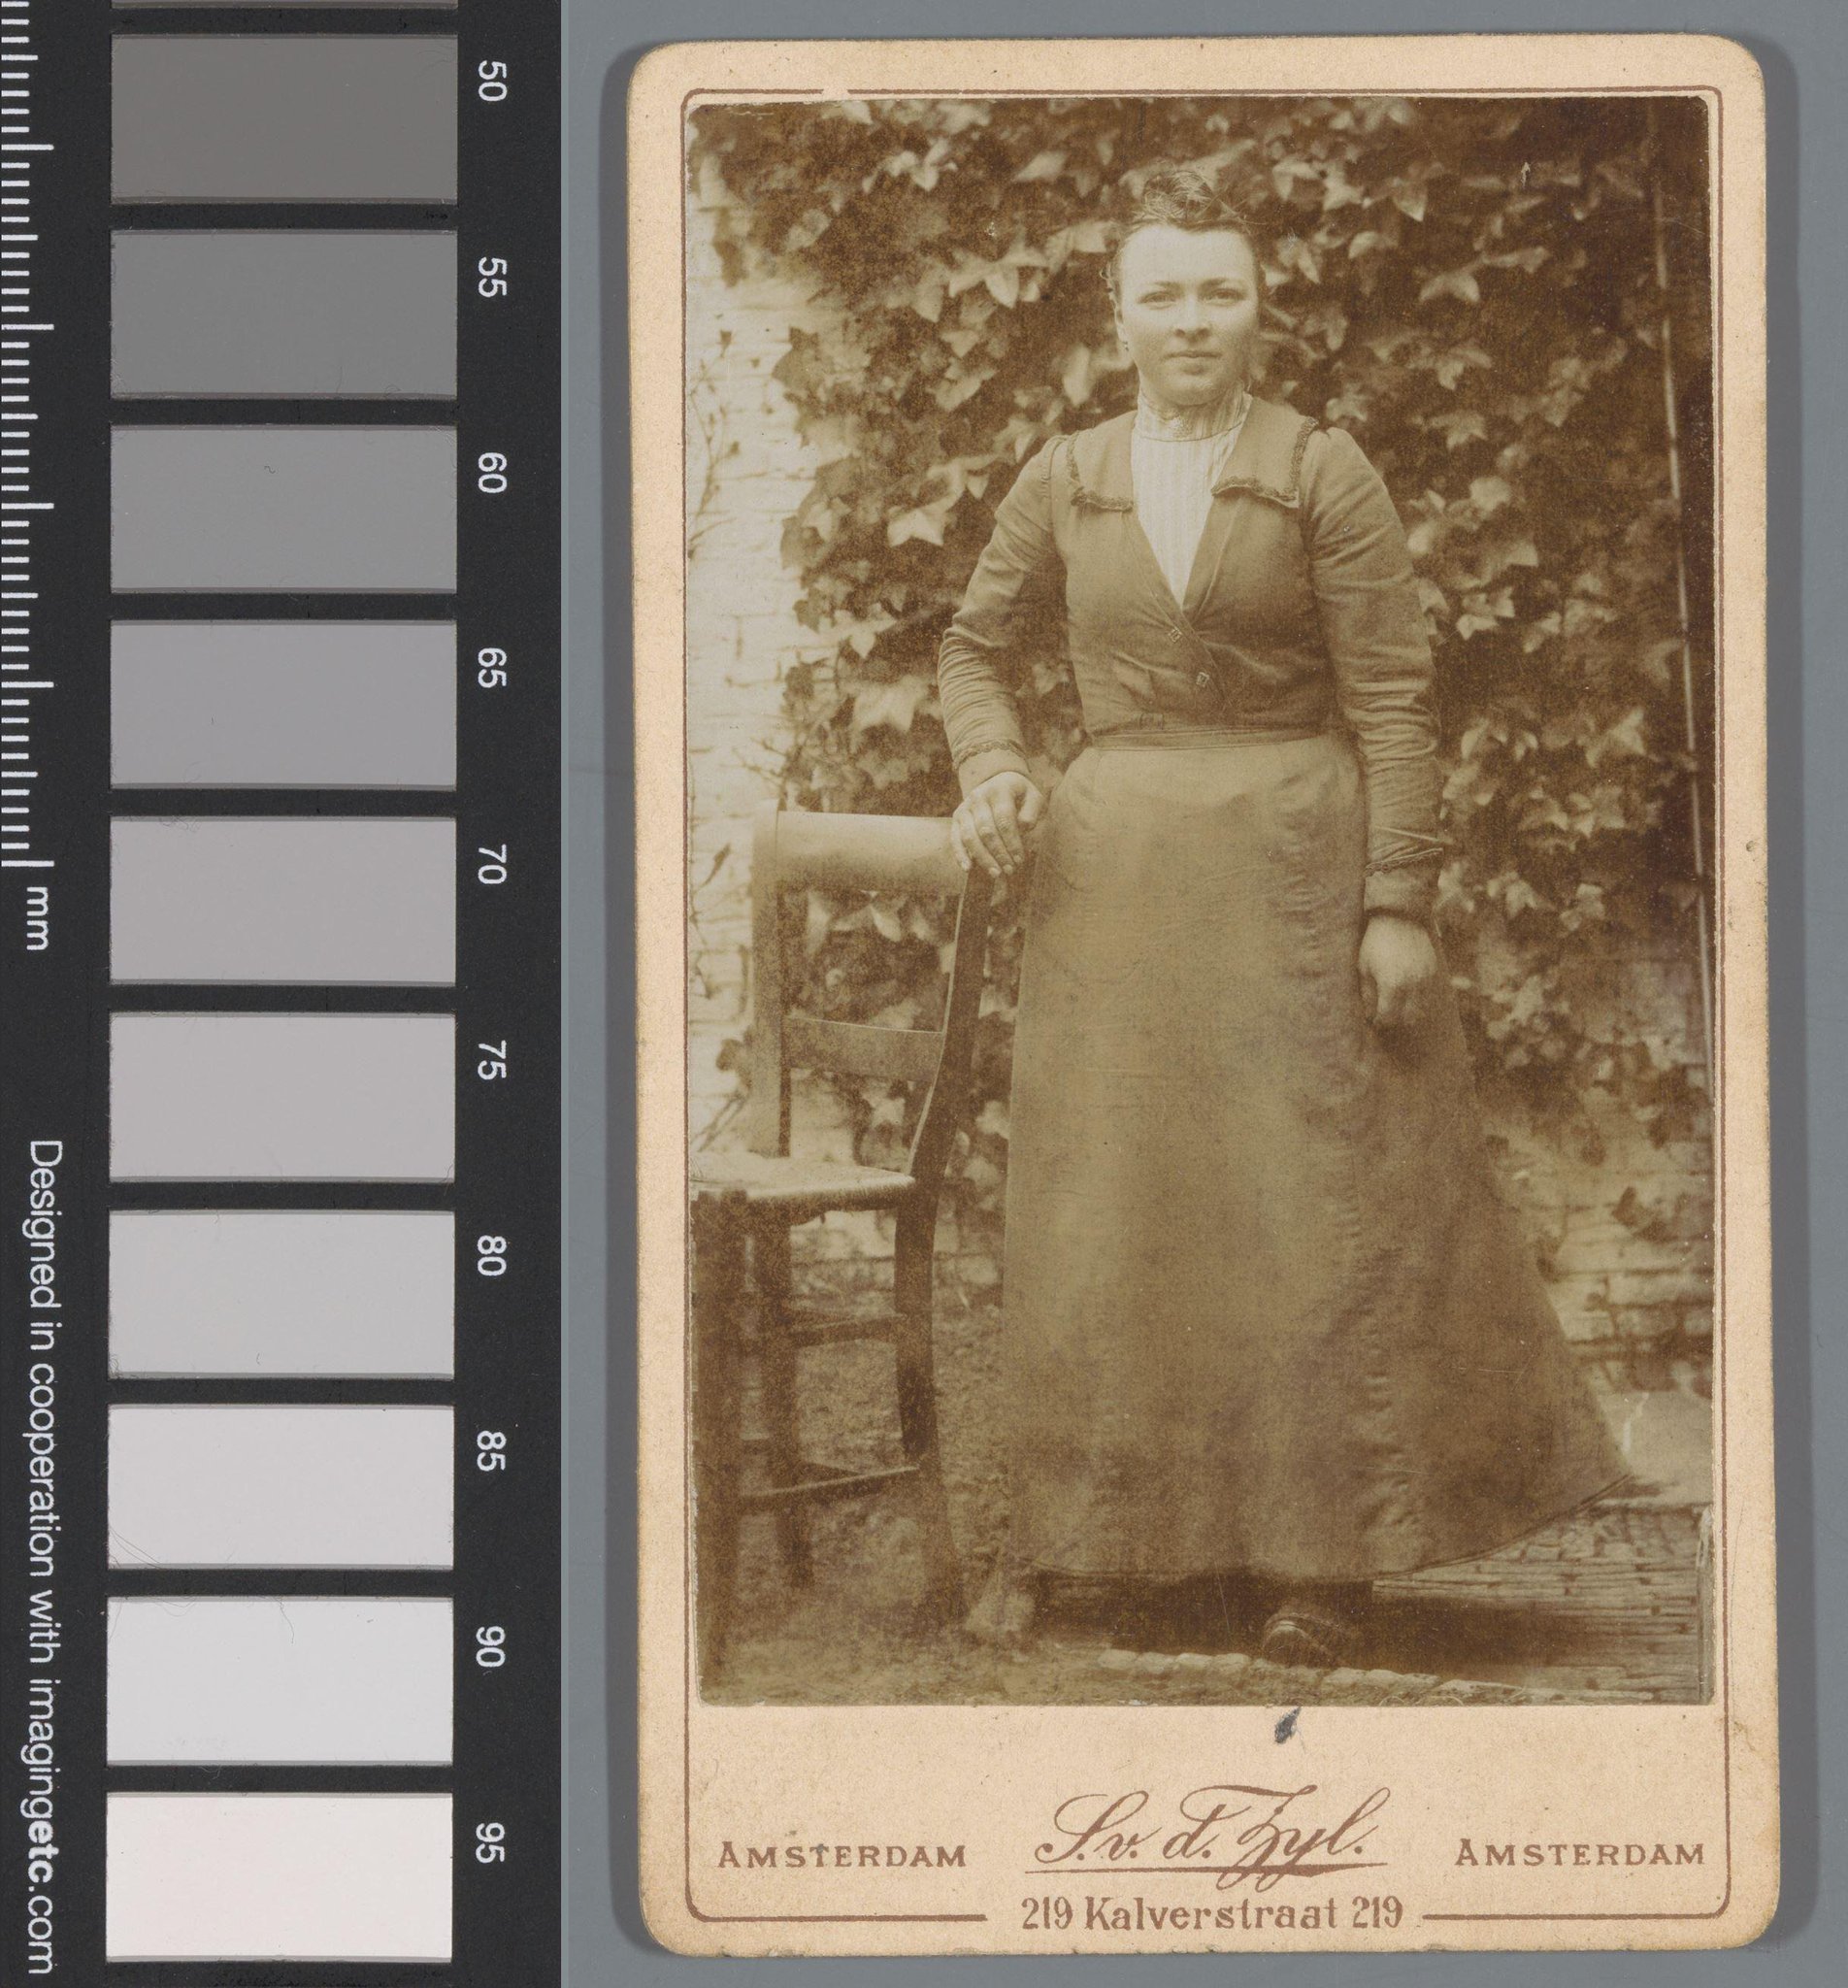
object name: carte de visite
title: Portret van een onbekende vrouw buiten bij een muur met klimop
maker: sander van der zijl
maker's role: fotograaf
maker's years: 1852-1935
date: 1901-1907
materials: paper, cardboard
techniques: gelatin silver print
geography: amsterdam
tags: adult woman, anonymous historical person portrayed, amsterdam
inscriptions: inscription: ‘Amsterdam/ S.v.d.Zijl./ Amsterdam/ 219 Kalverstraat 219.’, inscription: ‘Photographisch Atelier/ van/ Sander van der Zijl/ Amsterdam/ 219 Kalverstraat 219 b/d. Munt./ Voorheen gevestigd Nieuwendijk b/d. Dam./ Specialiteit in Kinderopnamen./ Vergrootingen van deze en andere Portretten/ tot levensgroote./ N.B. van deze Portretten kunnen steeds nabesteld worden./ 15 10 01/ Prager & Lojda, Berlin.’